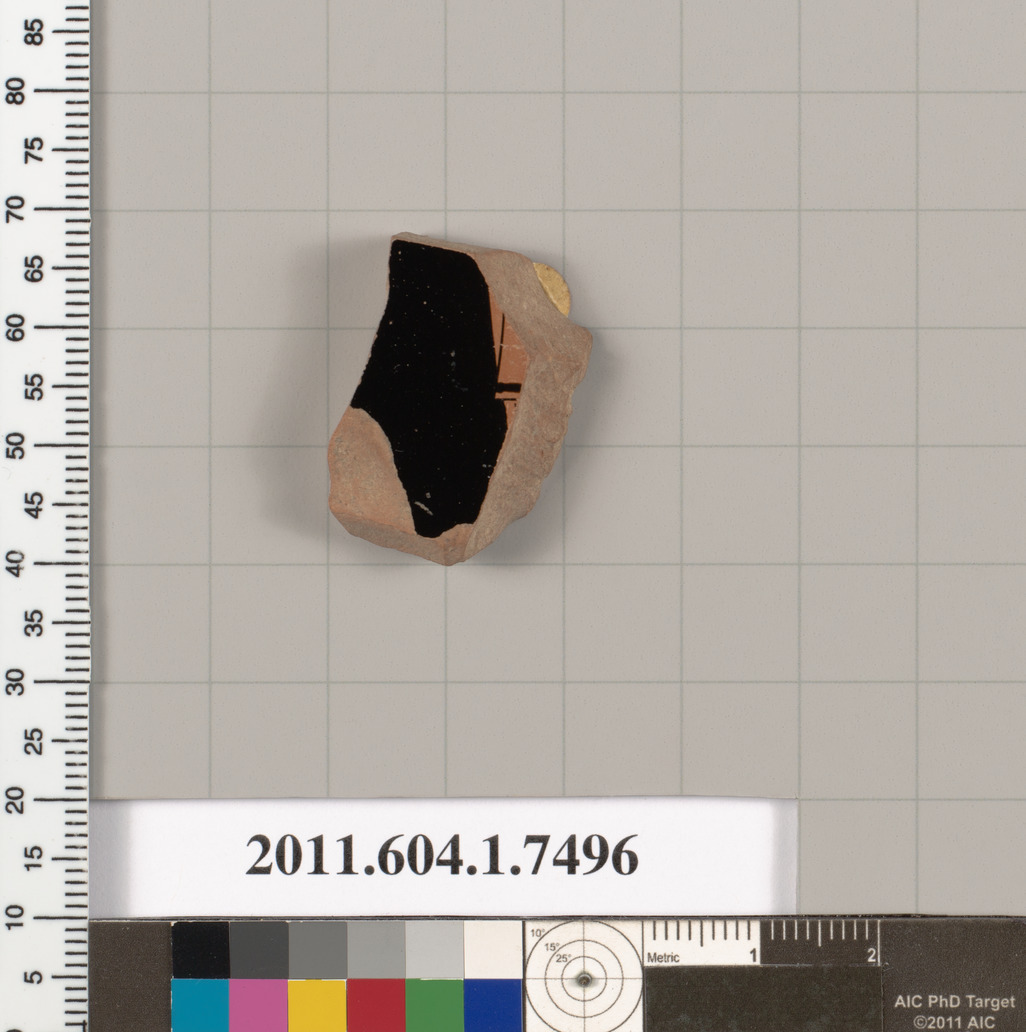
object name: kylix fragment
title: Terracotta fragment of a kylix (drinking cup)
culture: greek, attic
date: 460-450 BCE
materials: terracotta